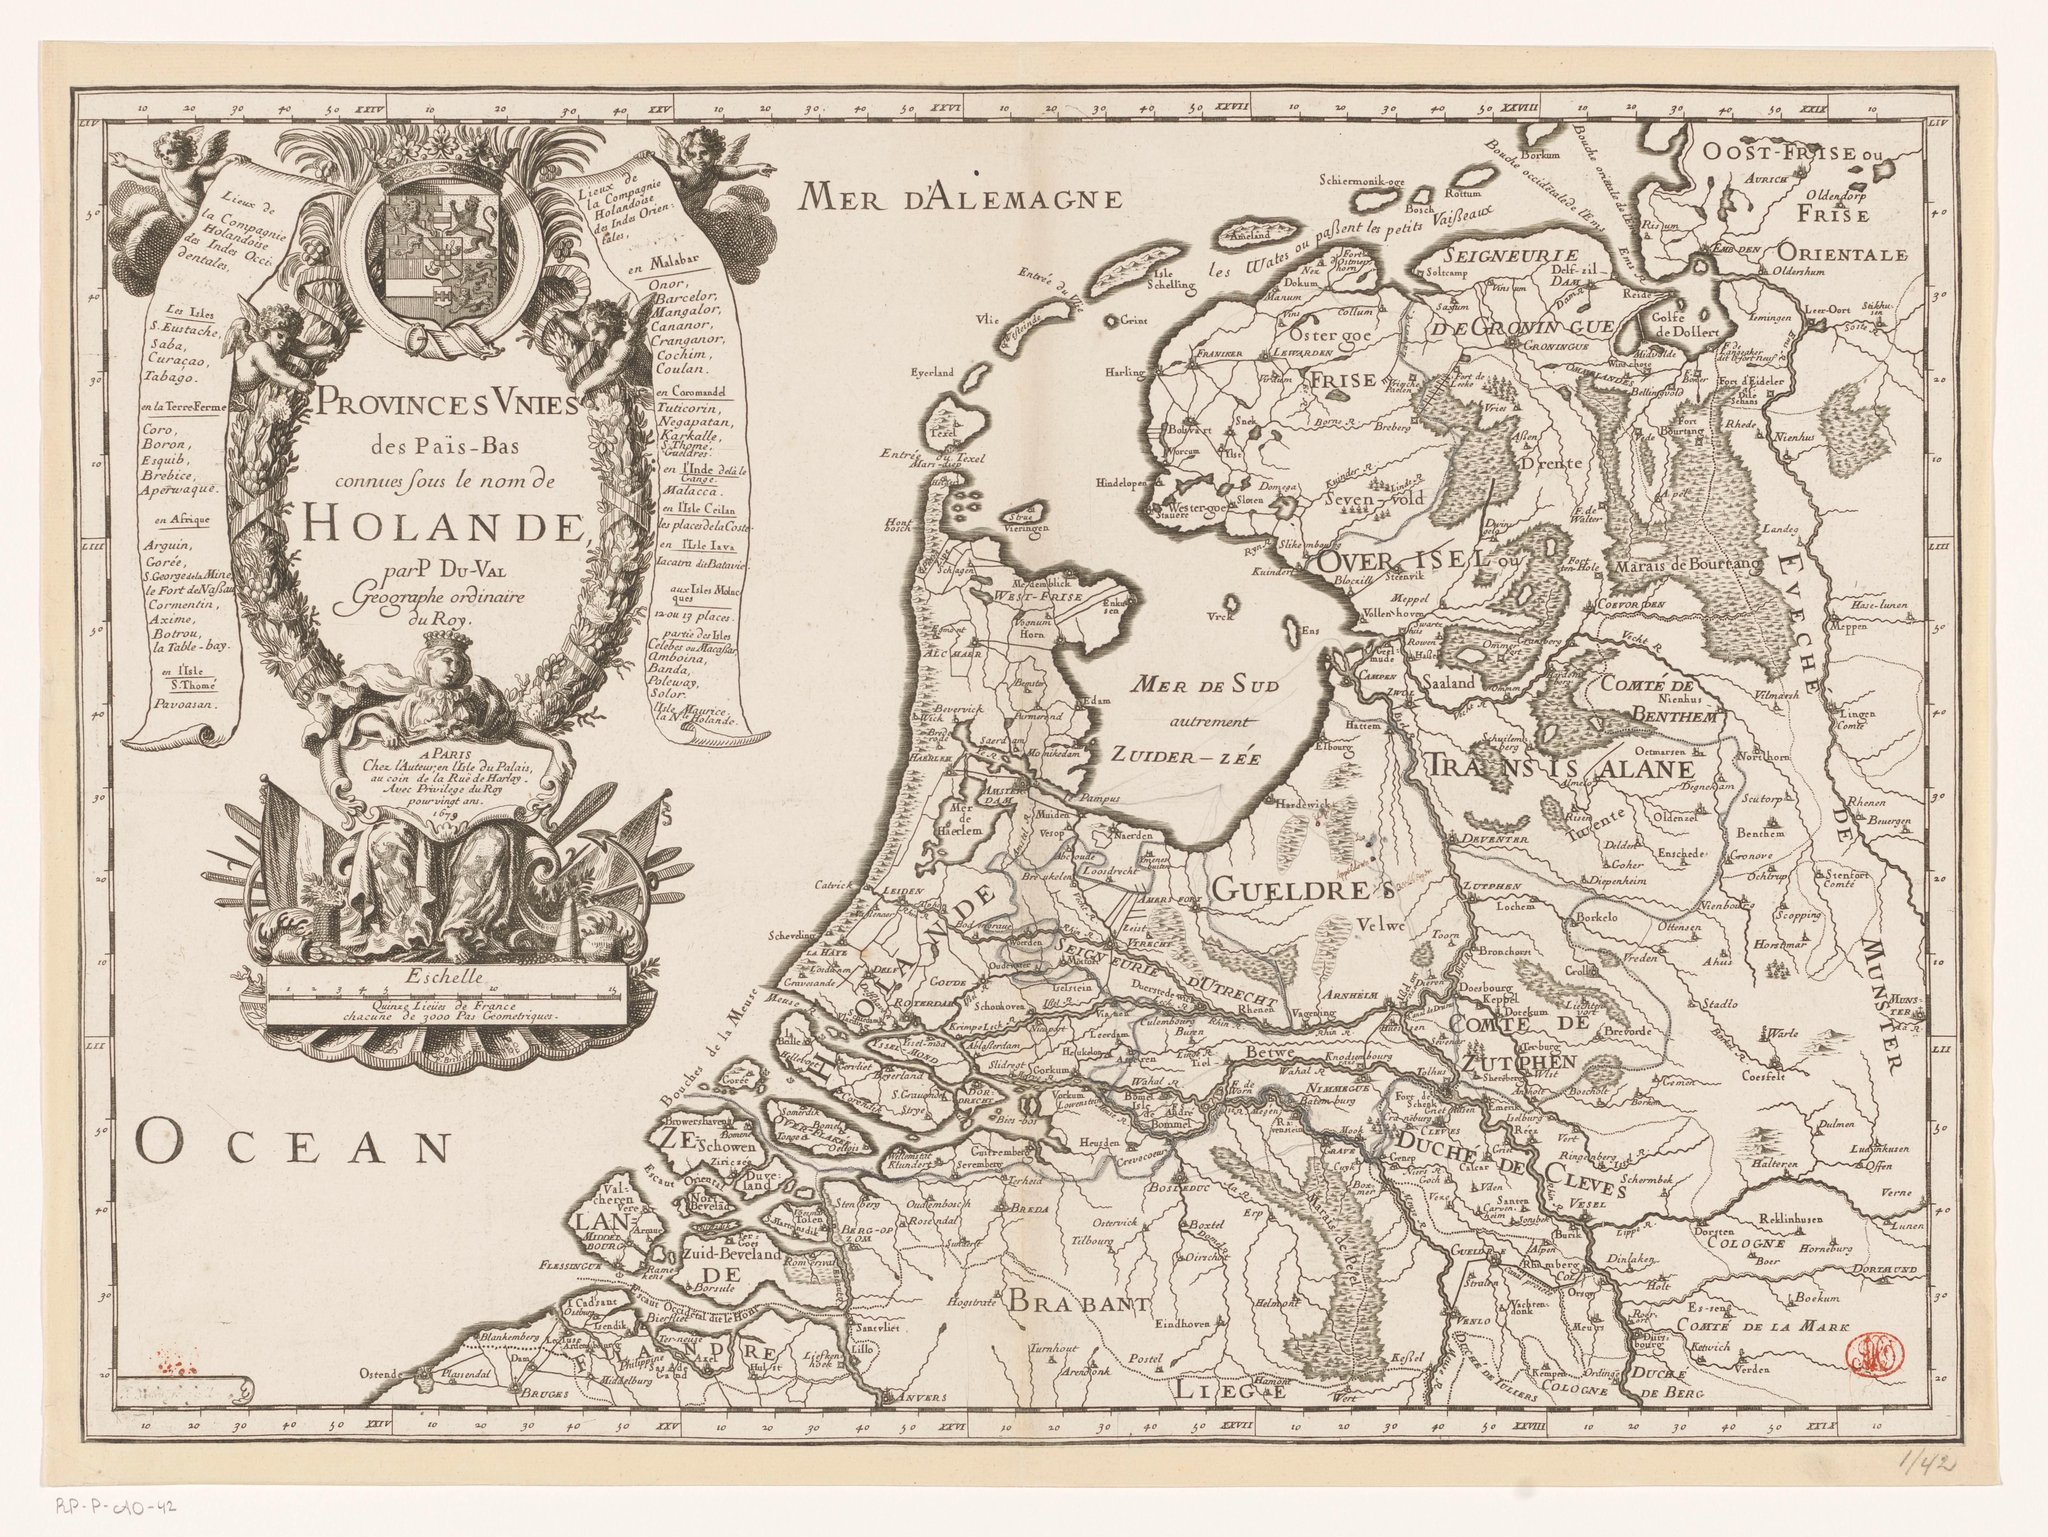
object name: print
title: Provinces Unies des Païs-Bas connues sous le nom de Holande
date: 1679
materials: paper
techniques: engraving, etching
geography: paris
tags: coat of arms (as symbol of the state, etc.), maps of separate countries or regions, netherlands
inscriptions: collector's mark: Lugt 2228, collector's mark: Lugt 195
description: Franse kaart van de Republiek. Linksboven cartouche met titel, daarboven het wapen van stadhouder Willem III. Onder titel een vrouwfiguur dat een cartouche draagt met plaats van uitgave, uitgever en privilege. Daaronder schaalstok: Quinze lieües de France chacune de 3000 pas geometriques. Links en rechts van cartouche een putto met een banderol waar de Nederlandse overzeese bezittingen in respectievelijk de West en de Oost op vermeld staan. Gradenverdeling langs de randen.